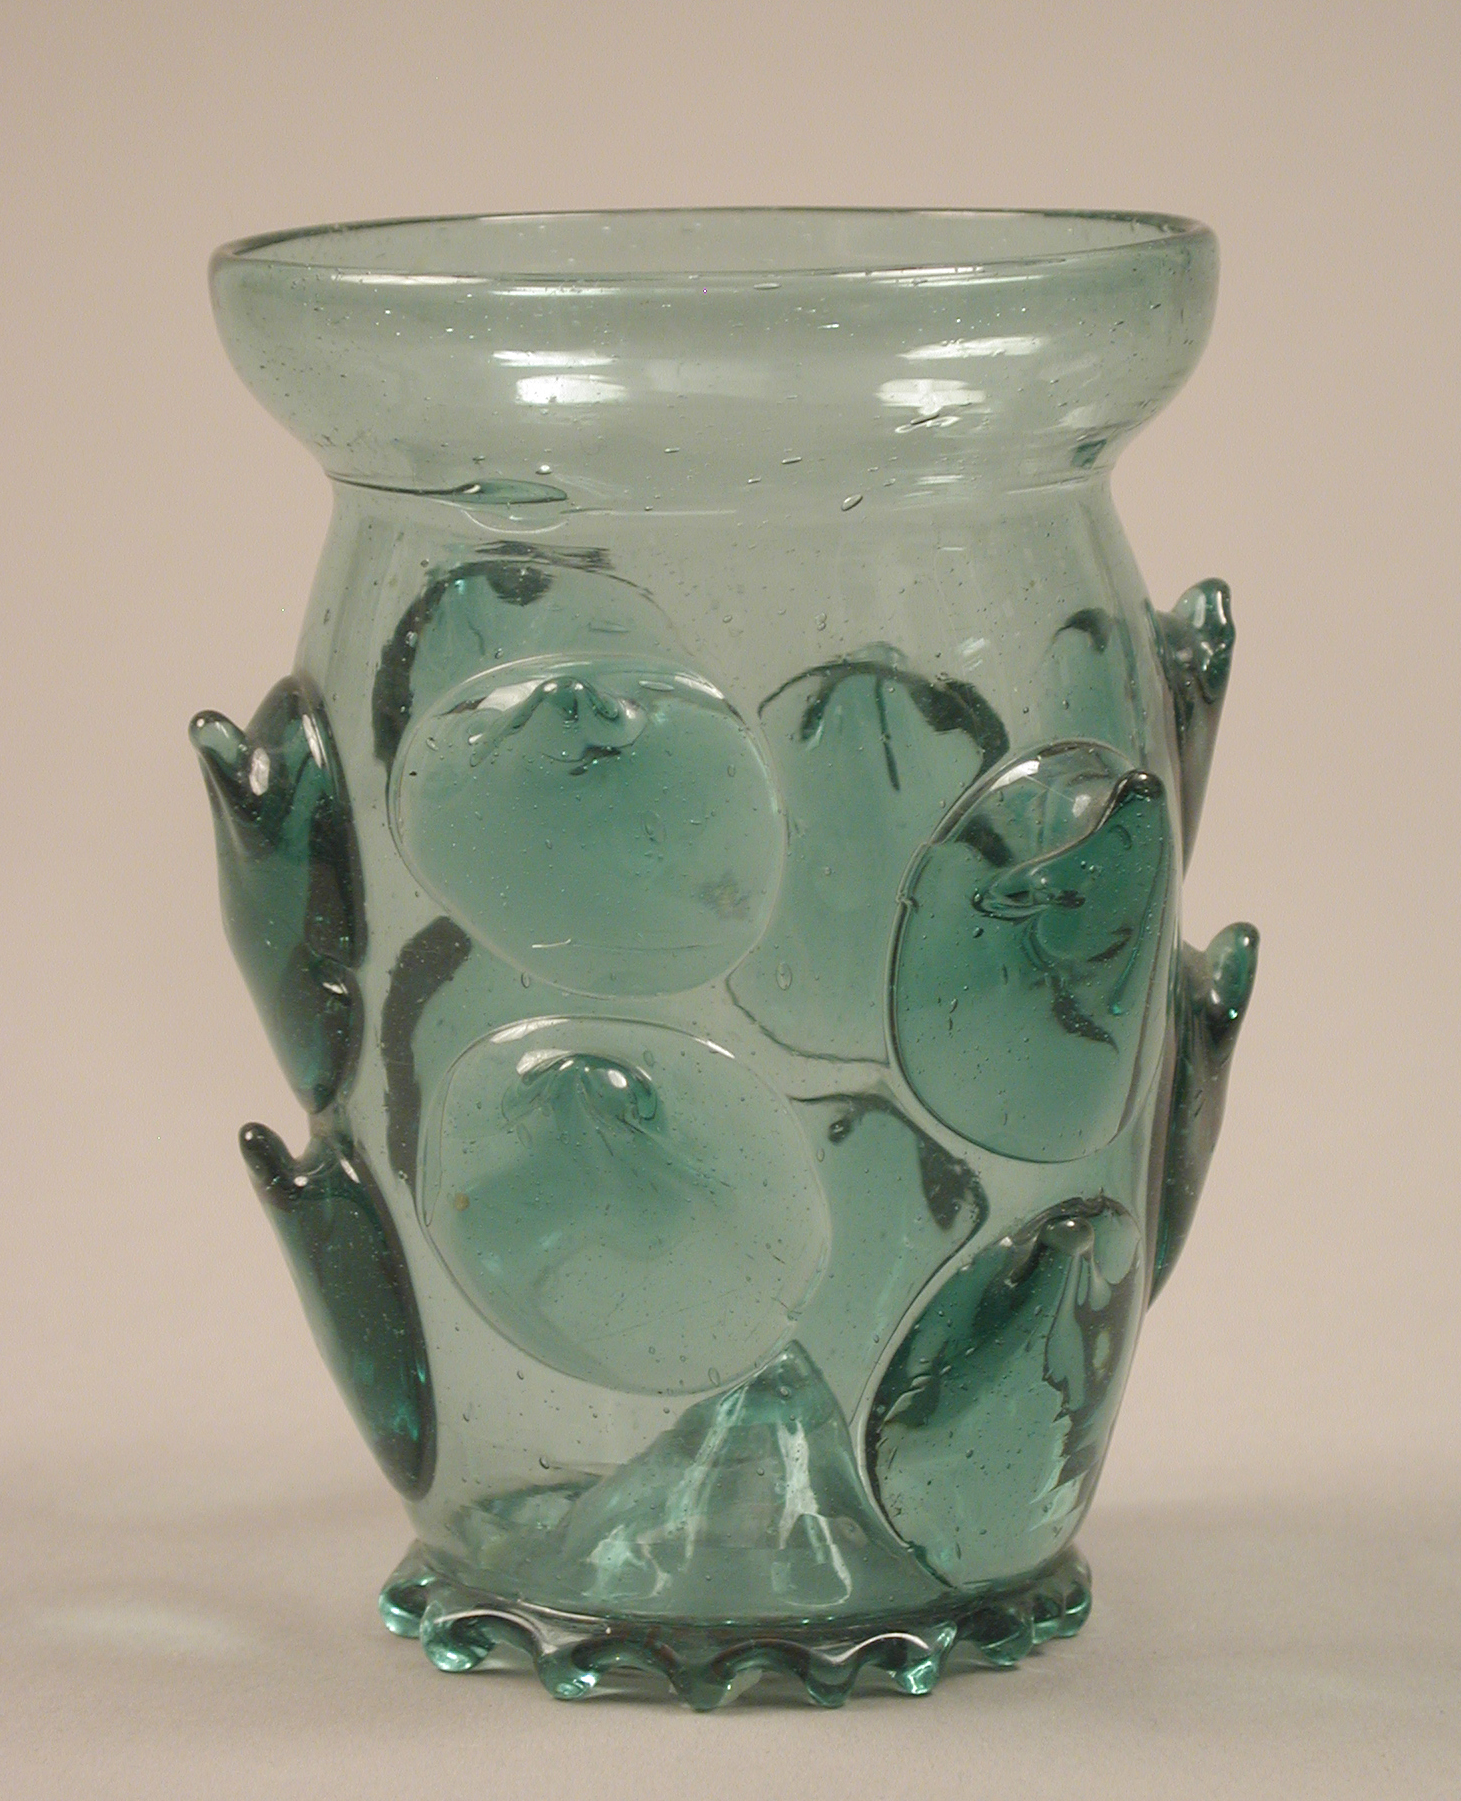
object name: beaker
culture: german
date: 1401-1500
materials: glass